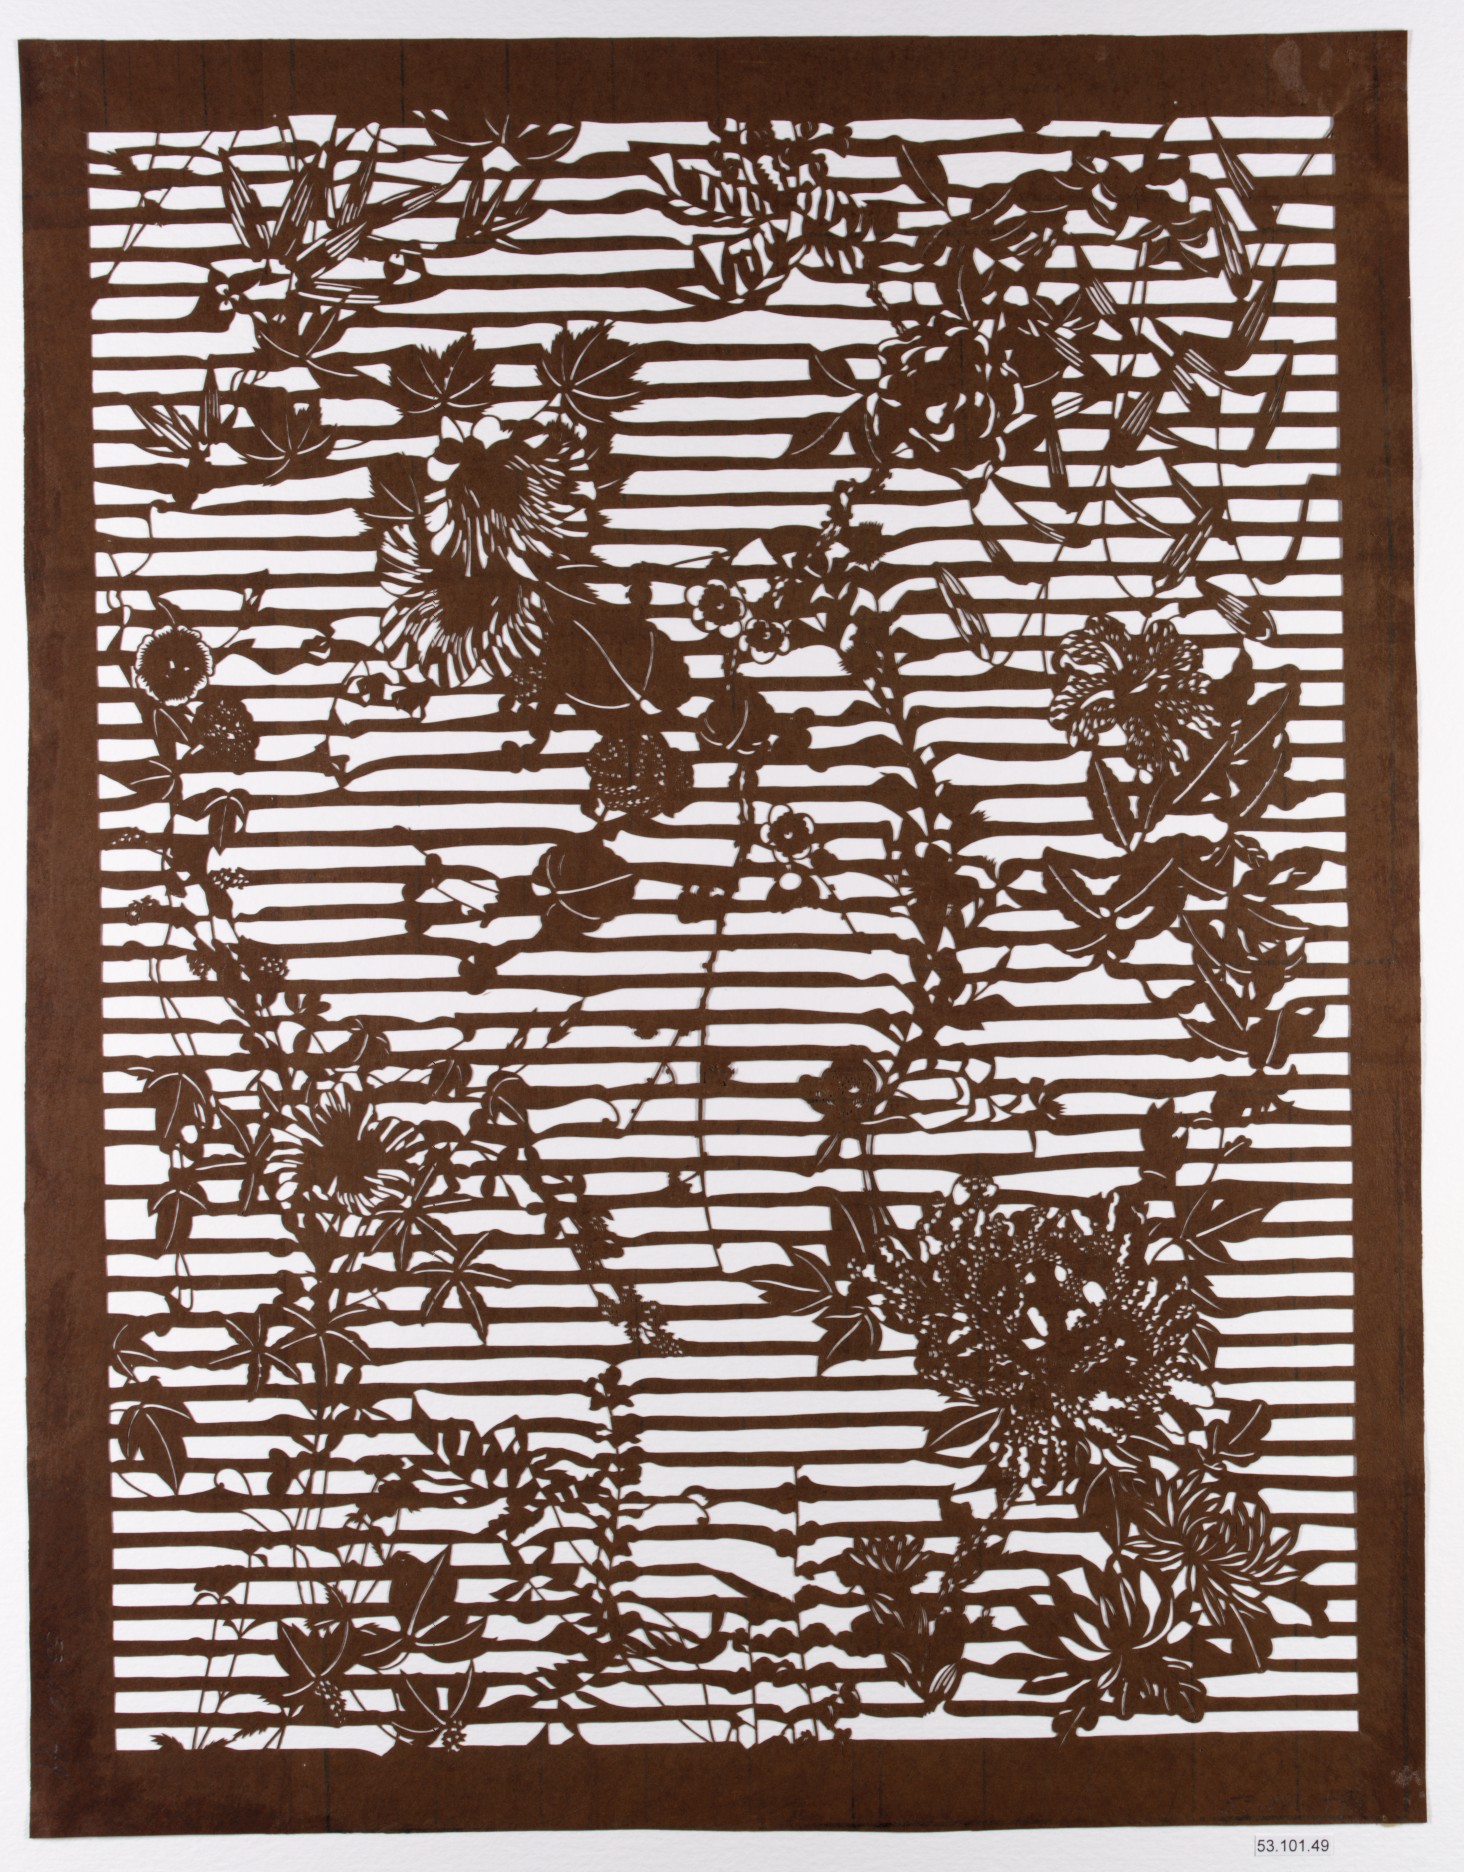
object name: stencil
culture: japanese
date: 1615-1868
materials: paper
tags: flowers